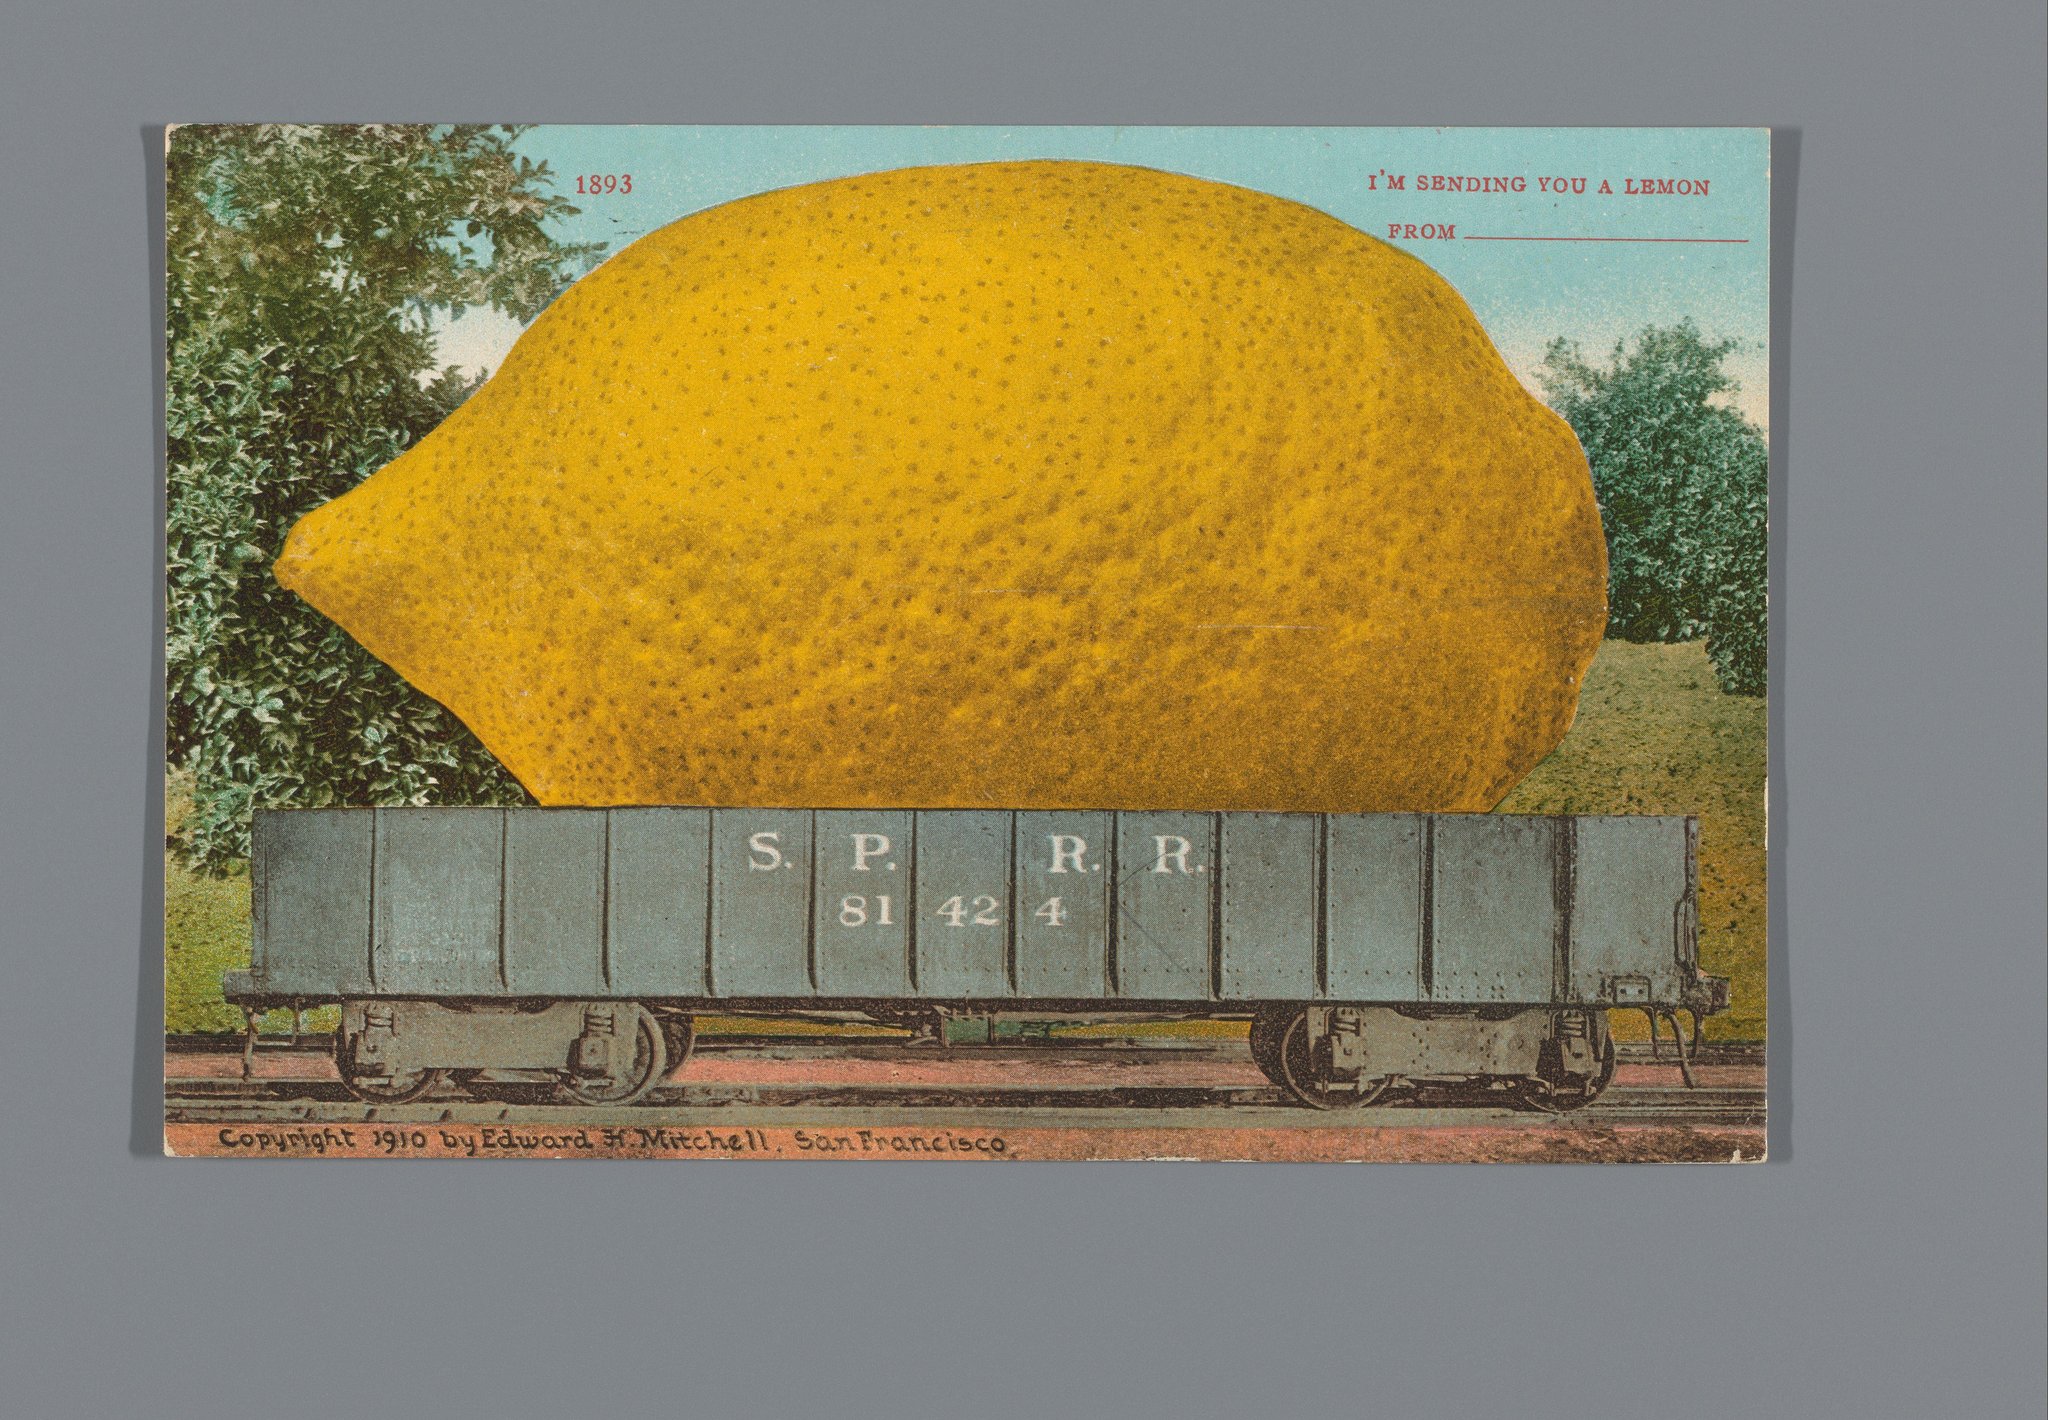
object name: ansichtkaart, prentbriefkaart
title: Een reusachtige citroen in een treinwagon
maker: edward henri mitchell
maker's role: publisher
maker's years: 1867-1932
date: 1910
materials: paper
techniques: lithograph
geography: san francisco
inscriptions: inscription: ‘Copyright 1910 by Edward H. Mitchell. San Francisco’, inscription: ‘I’M SENDING YOU A LEMON / FROM …….’, number: ‘1893’, inscription: ‘MADE IN AMERICA BY EDW. H. MITCHELL AT SAN FRANCISCO CALIFORNIA’